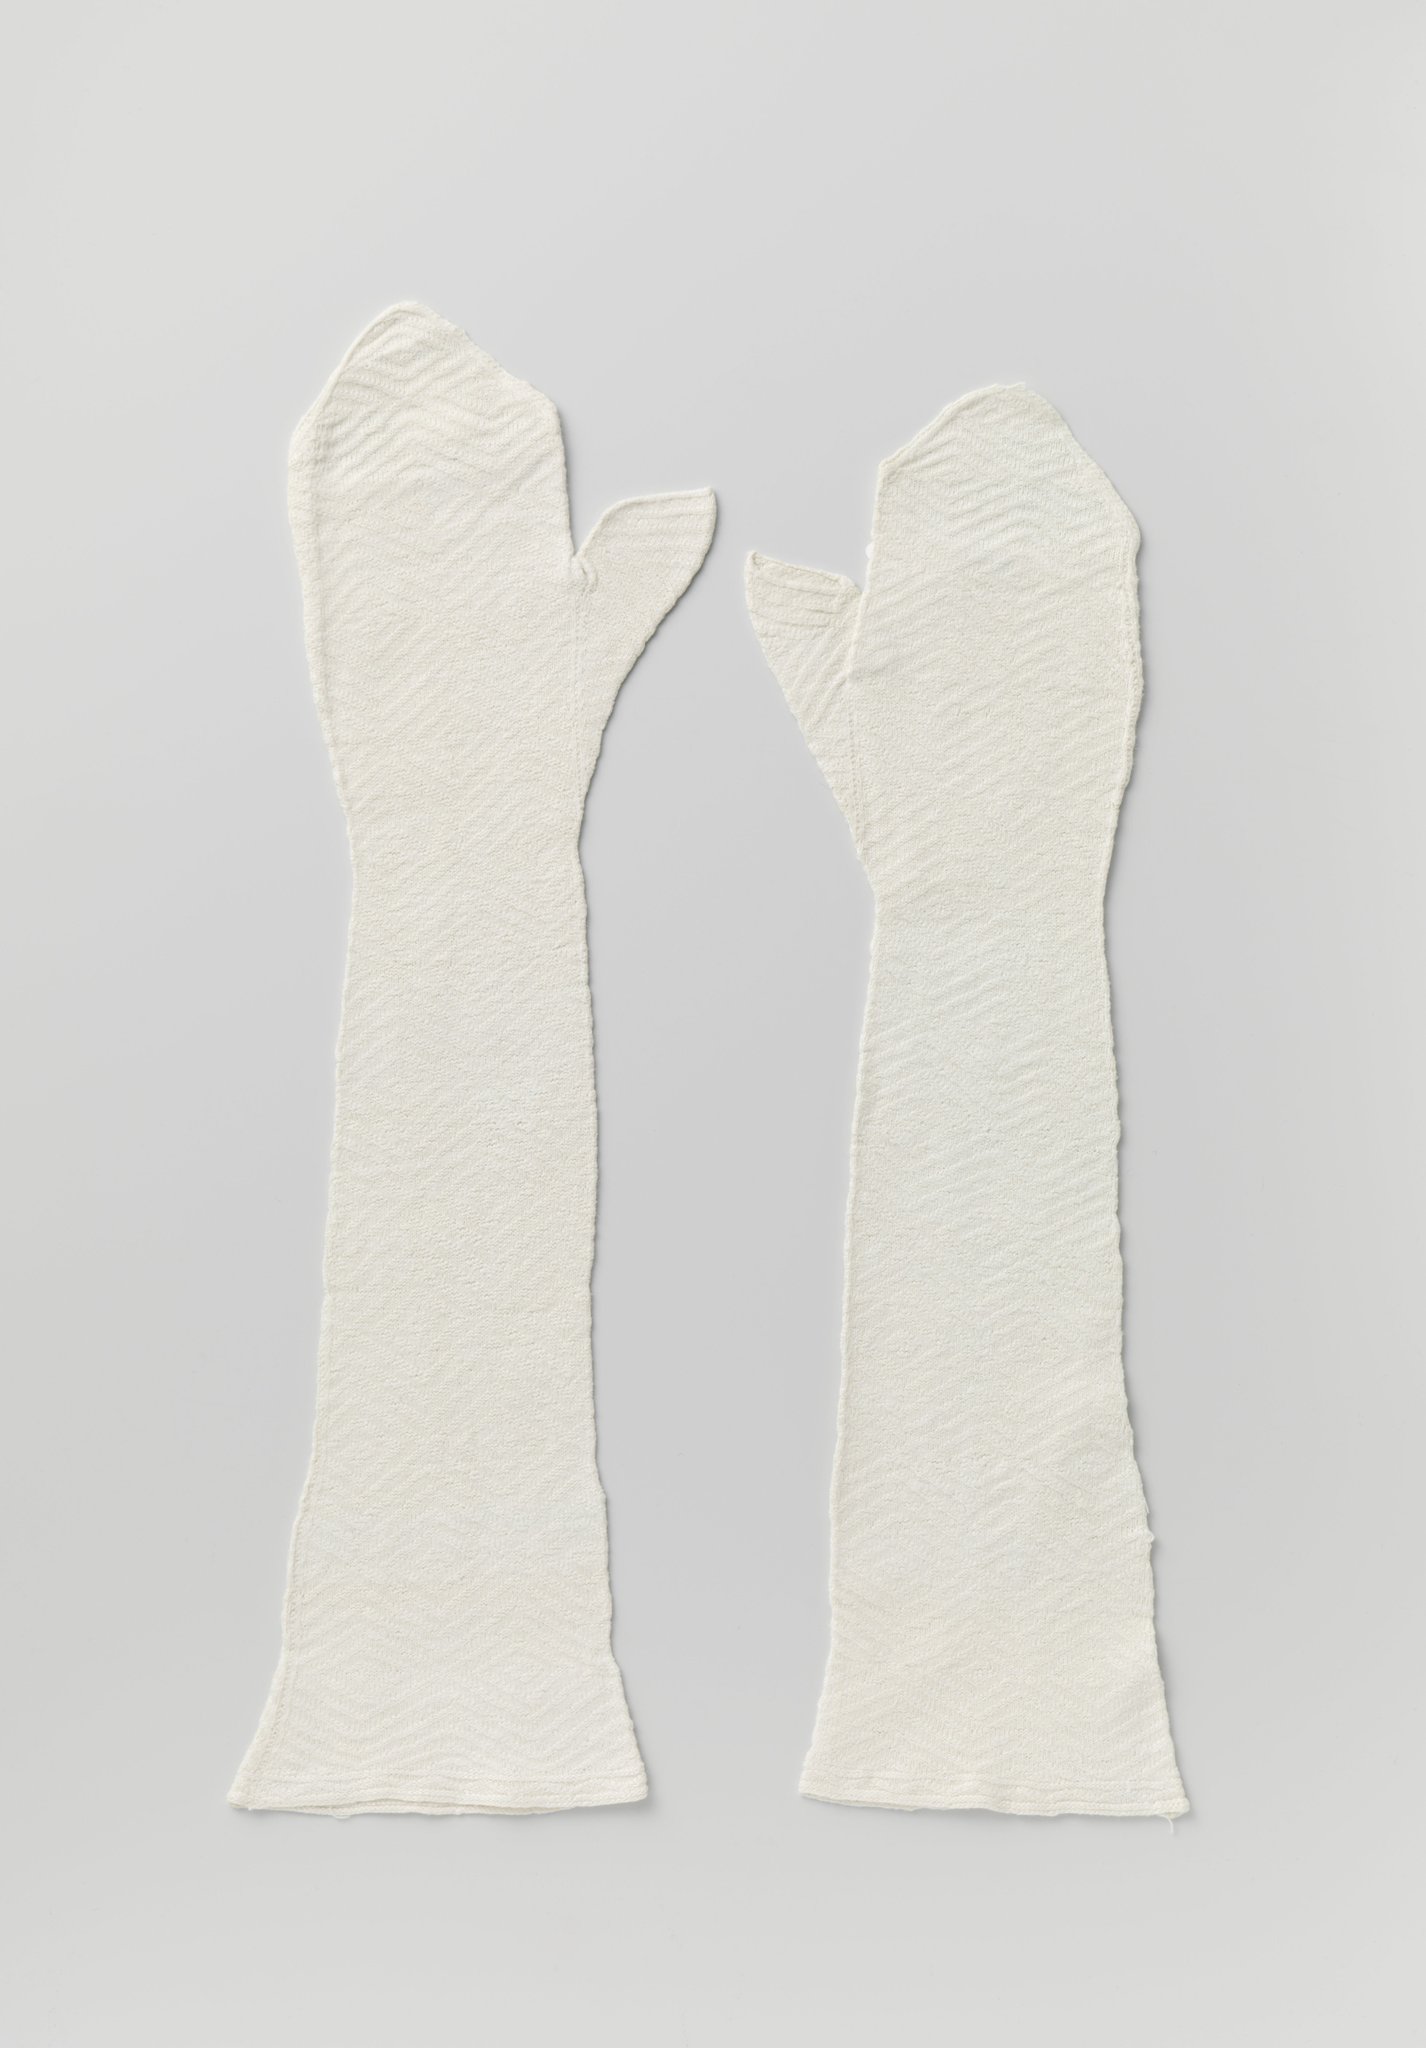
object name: mitt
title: Mitaine van witte gebreide katoen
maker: Anonymous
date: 1750-1800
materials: cotton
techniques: knitting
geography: zaanstreek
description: Mitaine van witte gebreide katoen met patroon in verspringende ruiten en apart aangebreide duim.